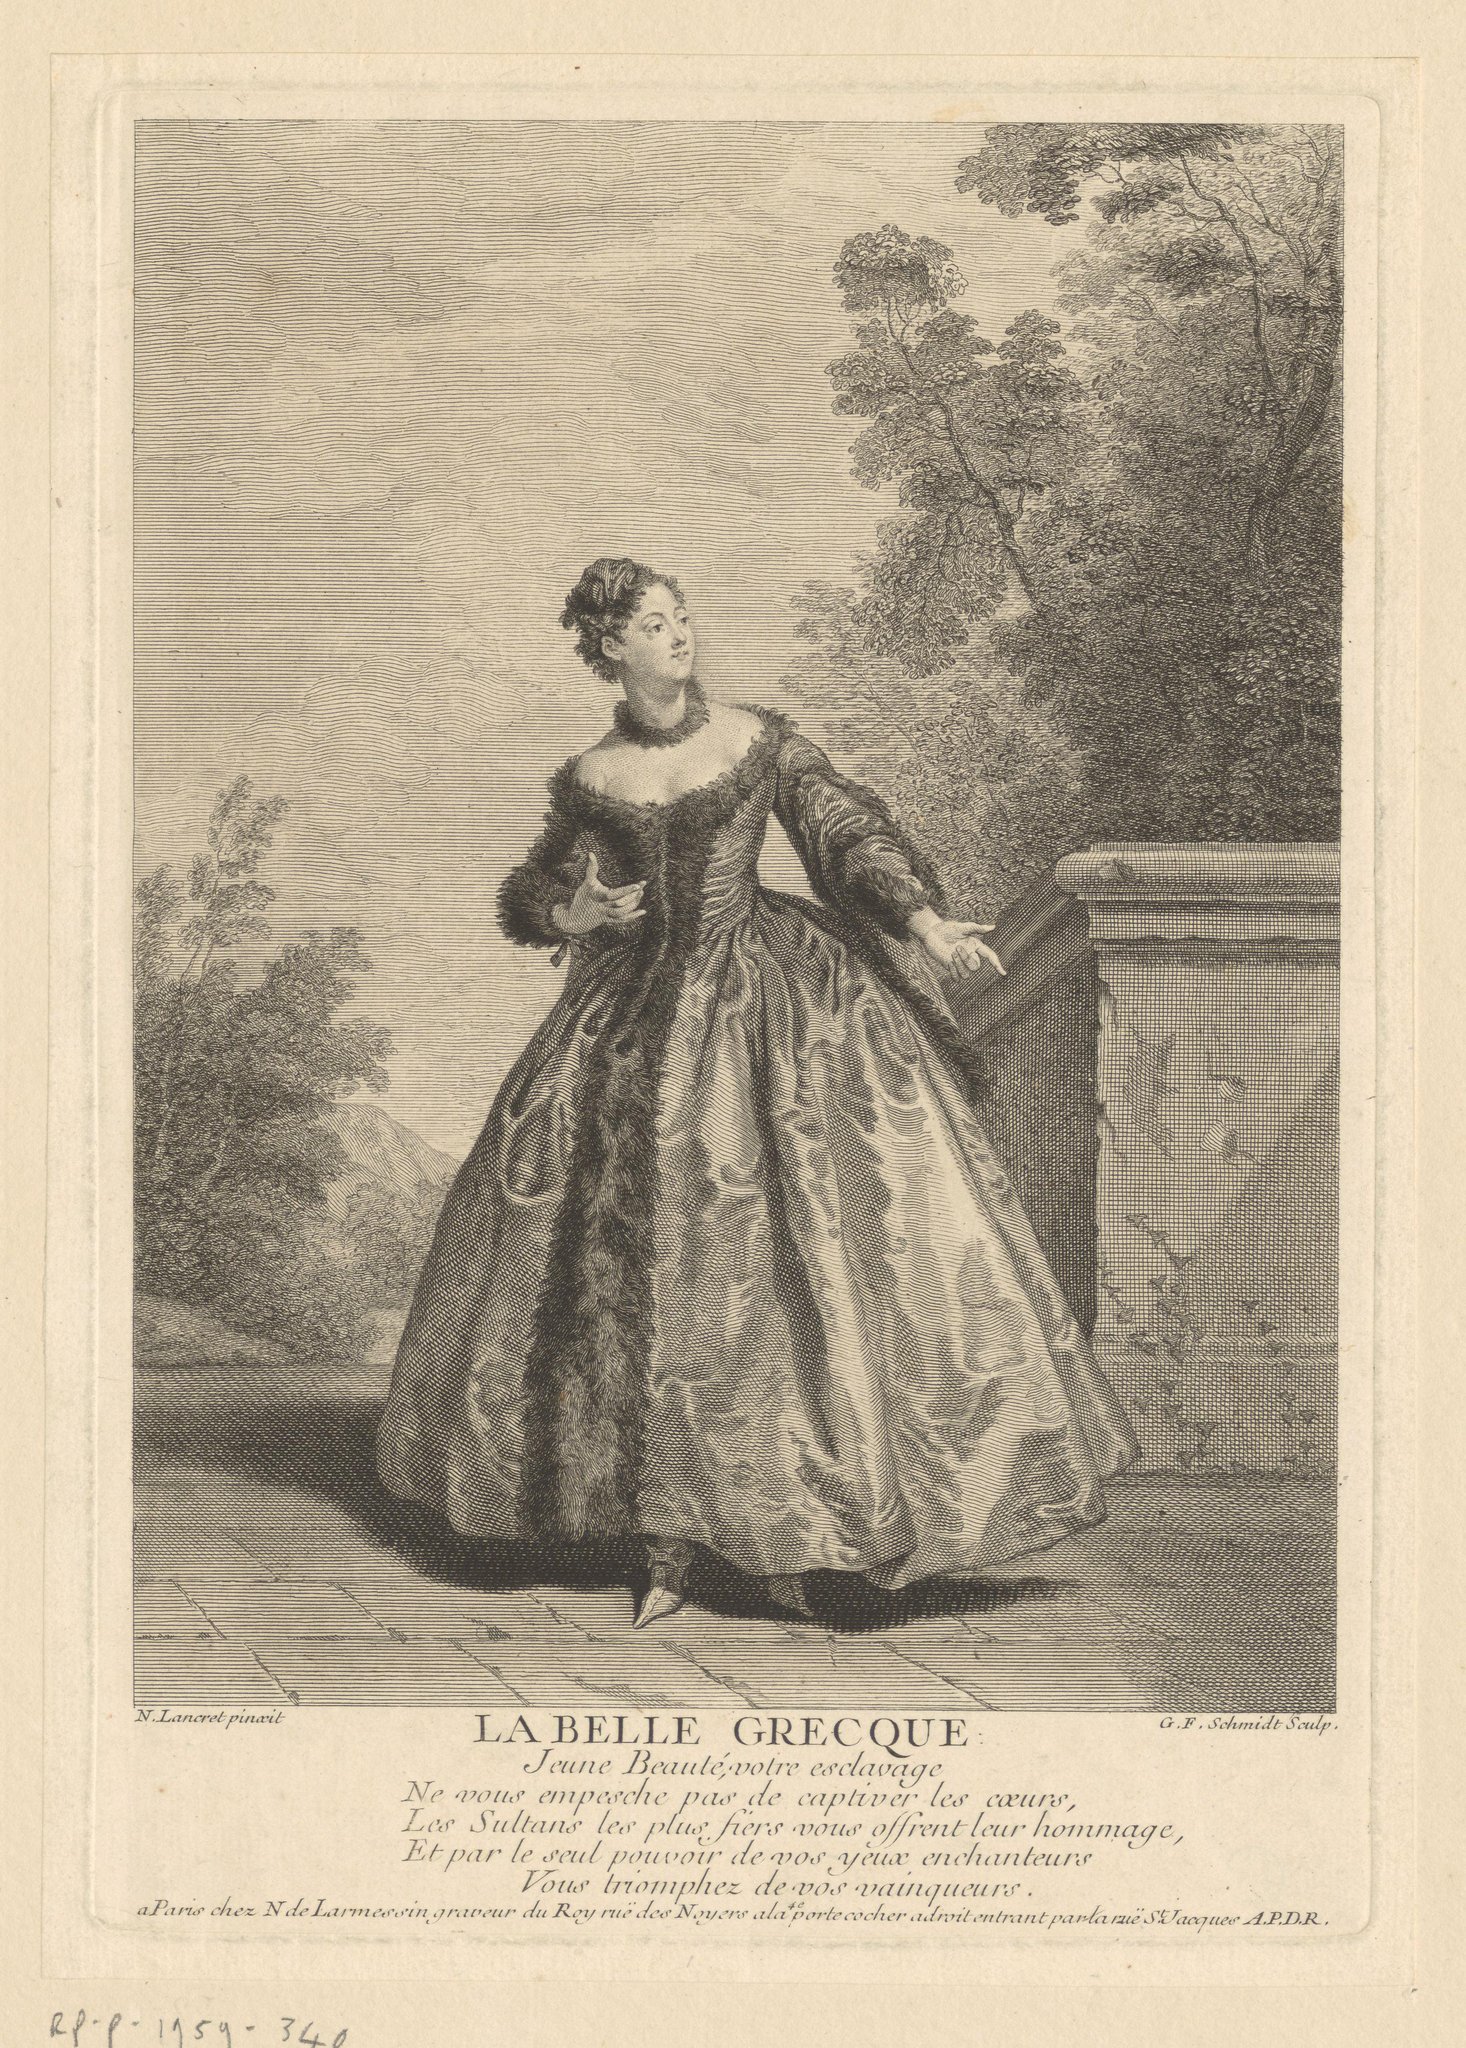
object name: print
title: Vrouw buiten in een jurk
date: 1722-1775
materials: paper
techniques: engraving, etching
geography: paris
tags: dress, gown: day dress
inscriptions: collector's mark: Lugt 2760, collector's mark: ‘M.’, collector's mark: Lugt 2228